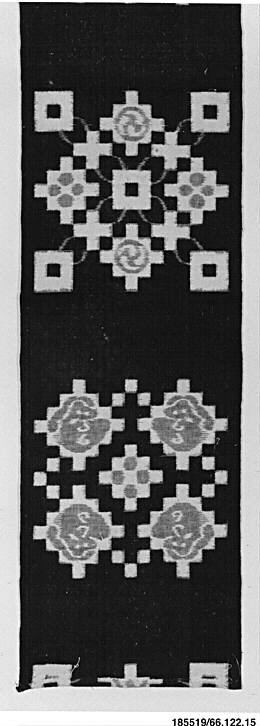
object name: piece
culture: japanese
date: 1801-1900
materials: cotton